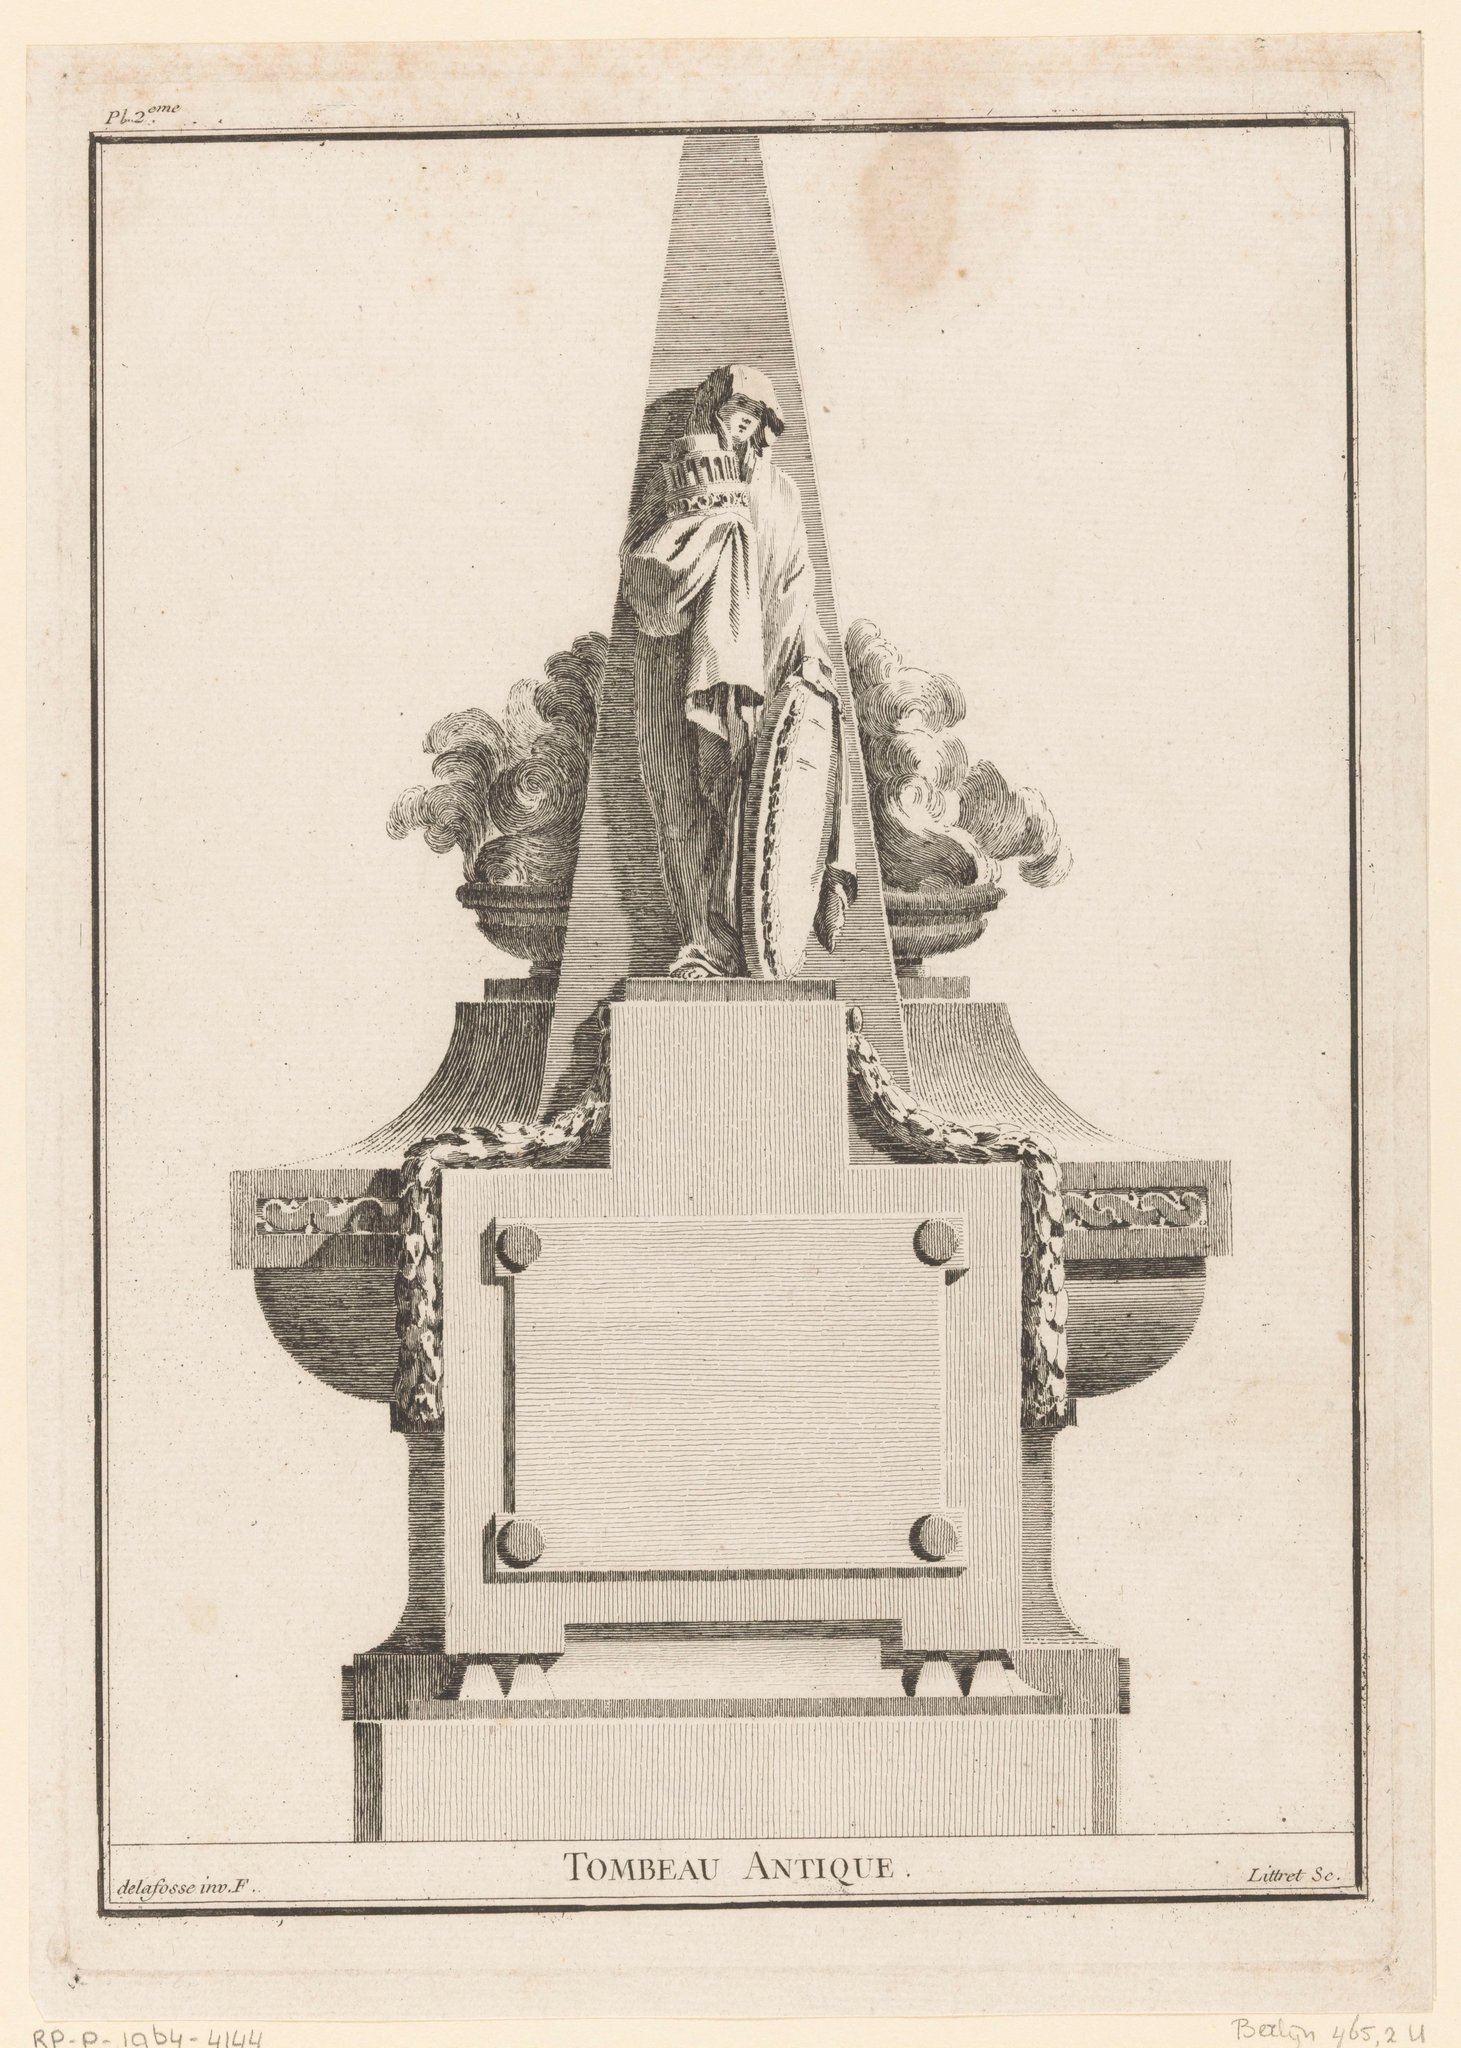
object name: print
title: Tombe met staande figuur en rookvaten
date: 1771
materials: paper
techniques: engraving, etching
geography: paris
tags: standing figure, grave, tomb, incense-burner ~ scents, perfumes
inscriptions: collector's mark: Lugt 2760, collector's mark: Lugt 2228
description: Een tombe met twee rookvaten en een staande figuur met een schild.